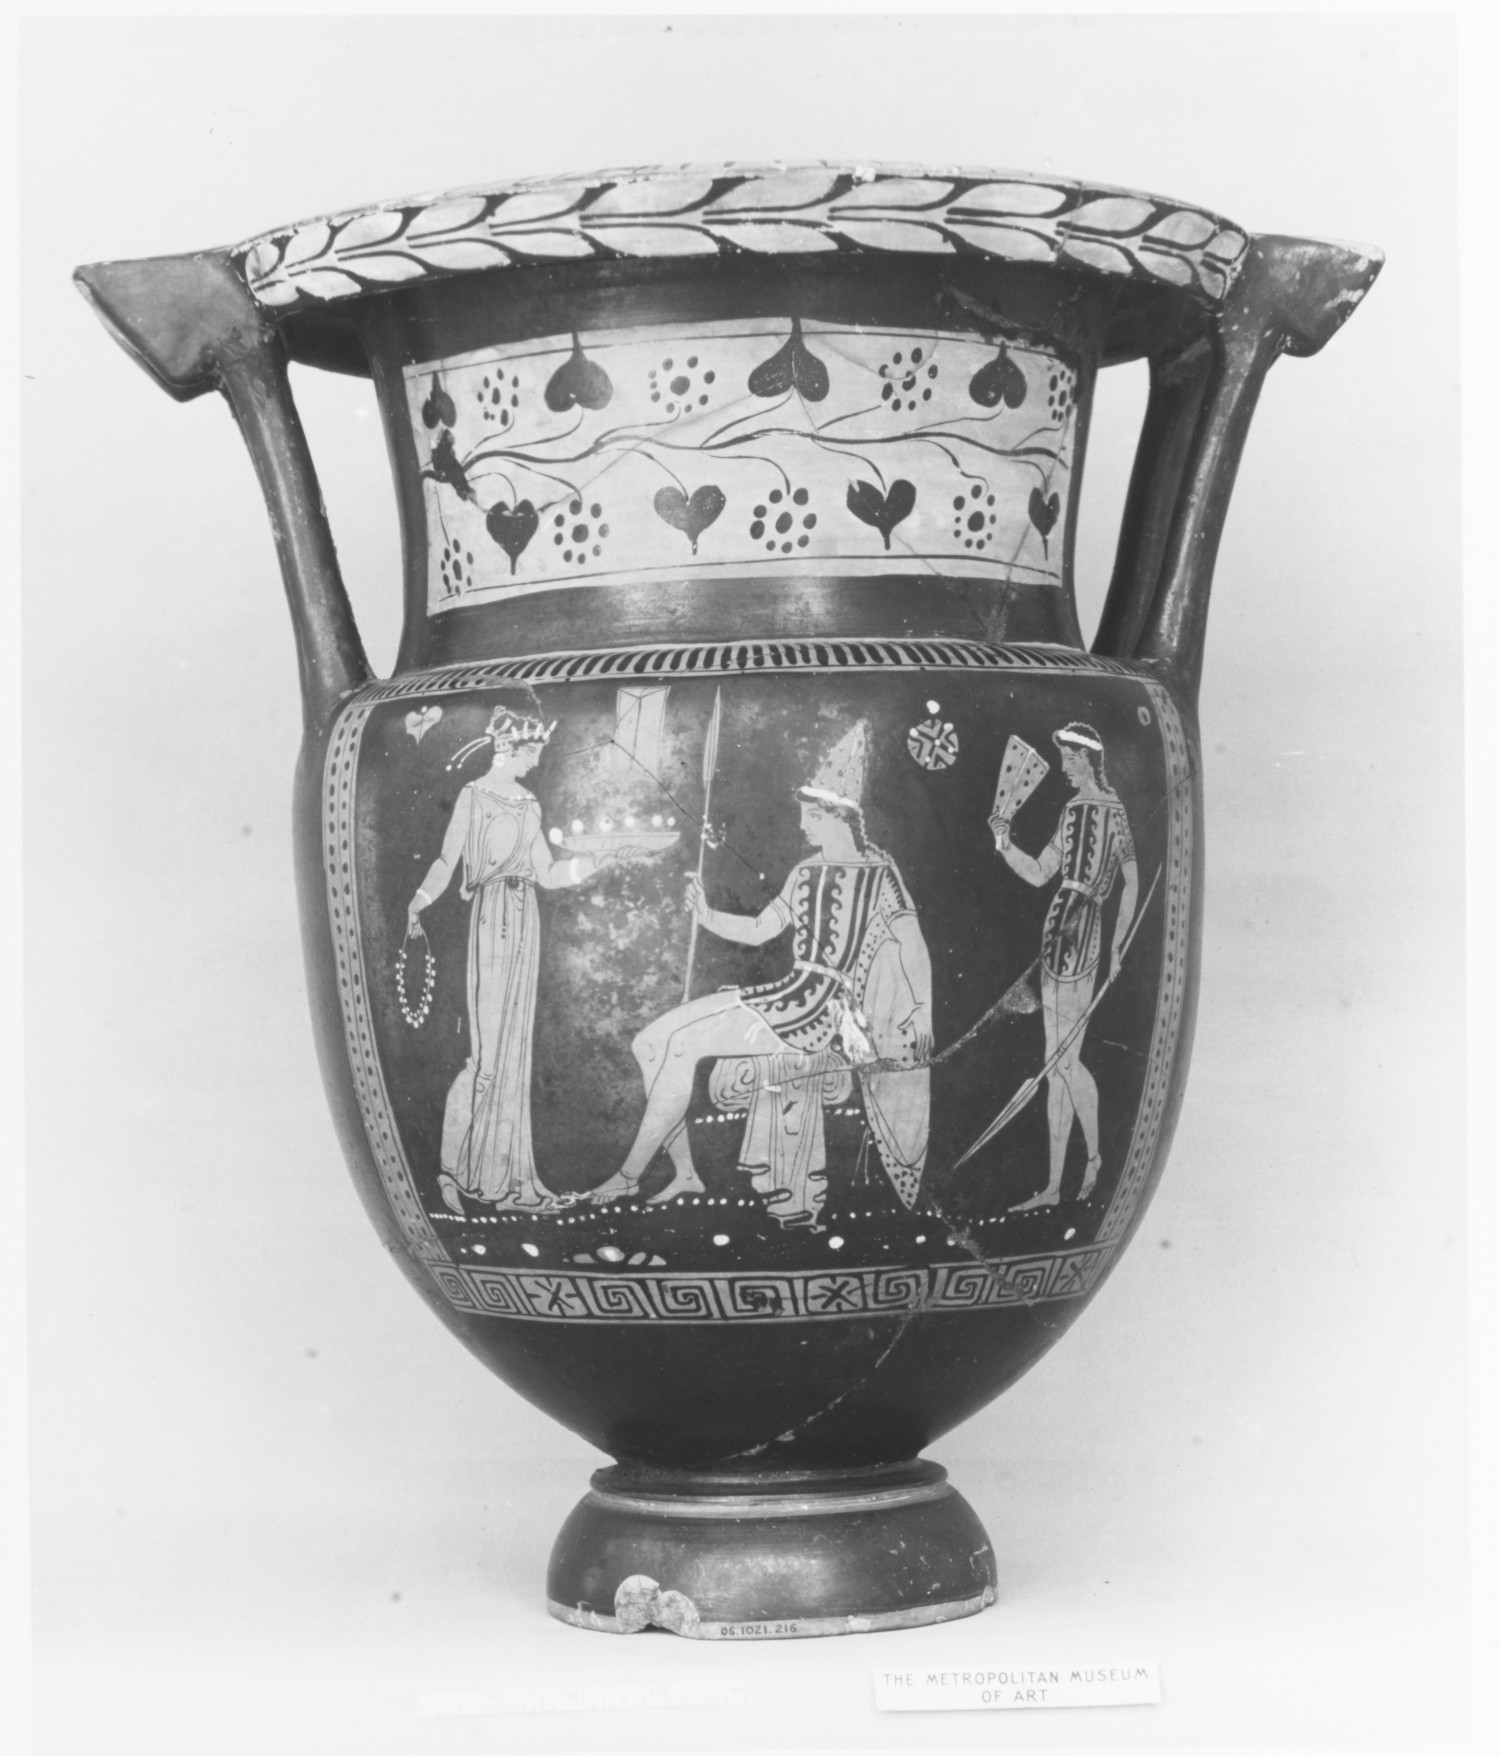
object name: column krater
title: Terracotta column-krater (mixing bowl)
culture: greek, south italian, apulian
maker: rodin painter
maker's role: artist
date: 380-360 BCE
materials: terracotta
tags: shields,spears,men,women,warriors